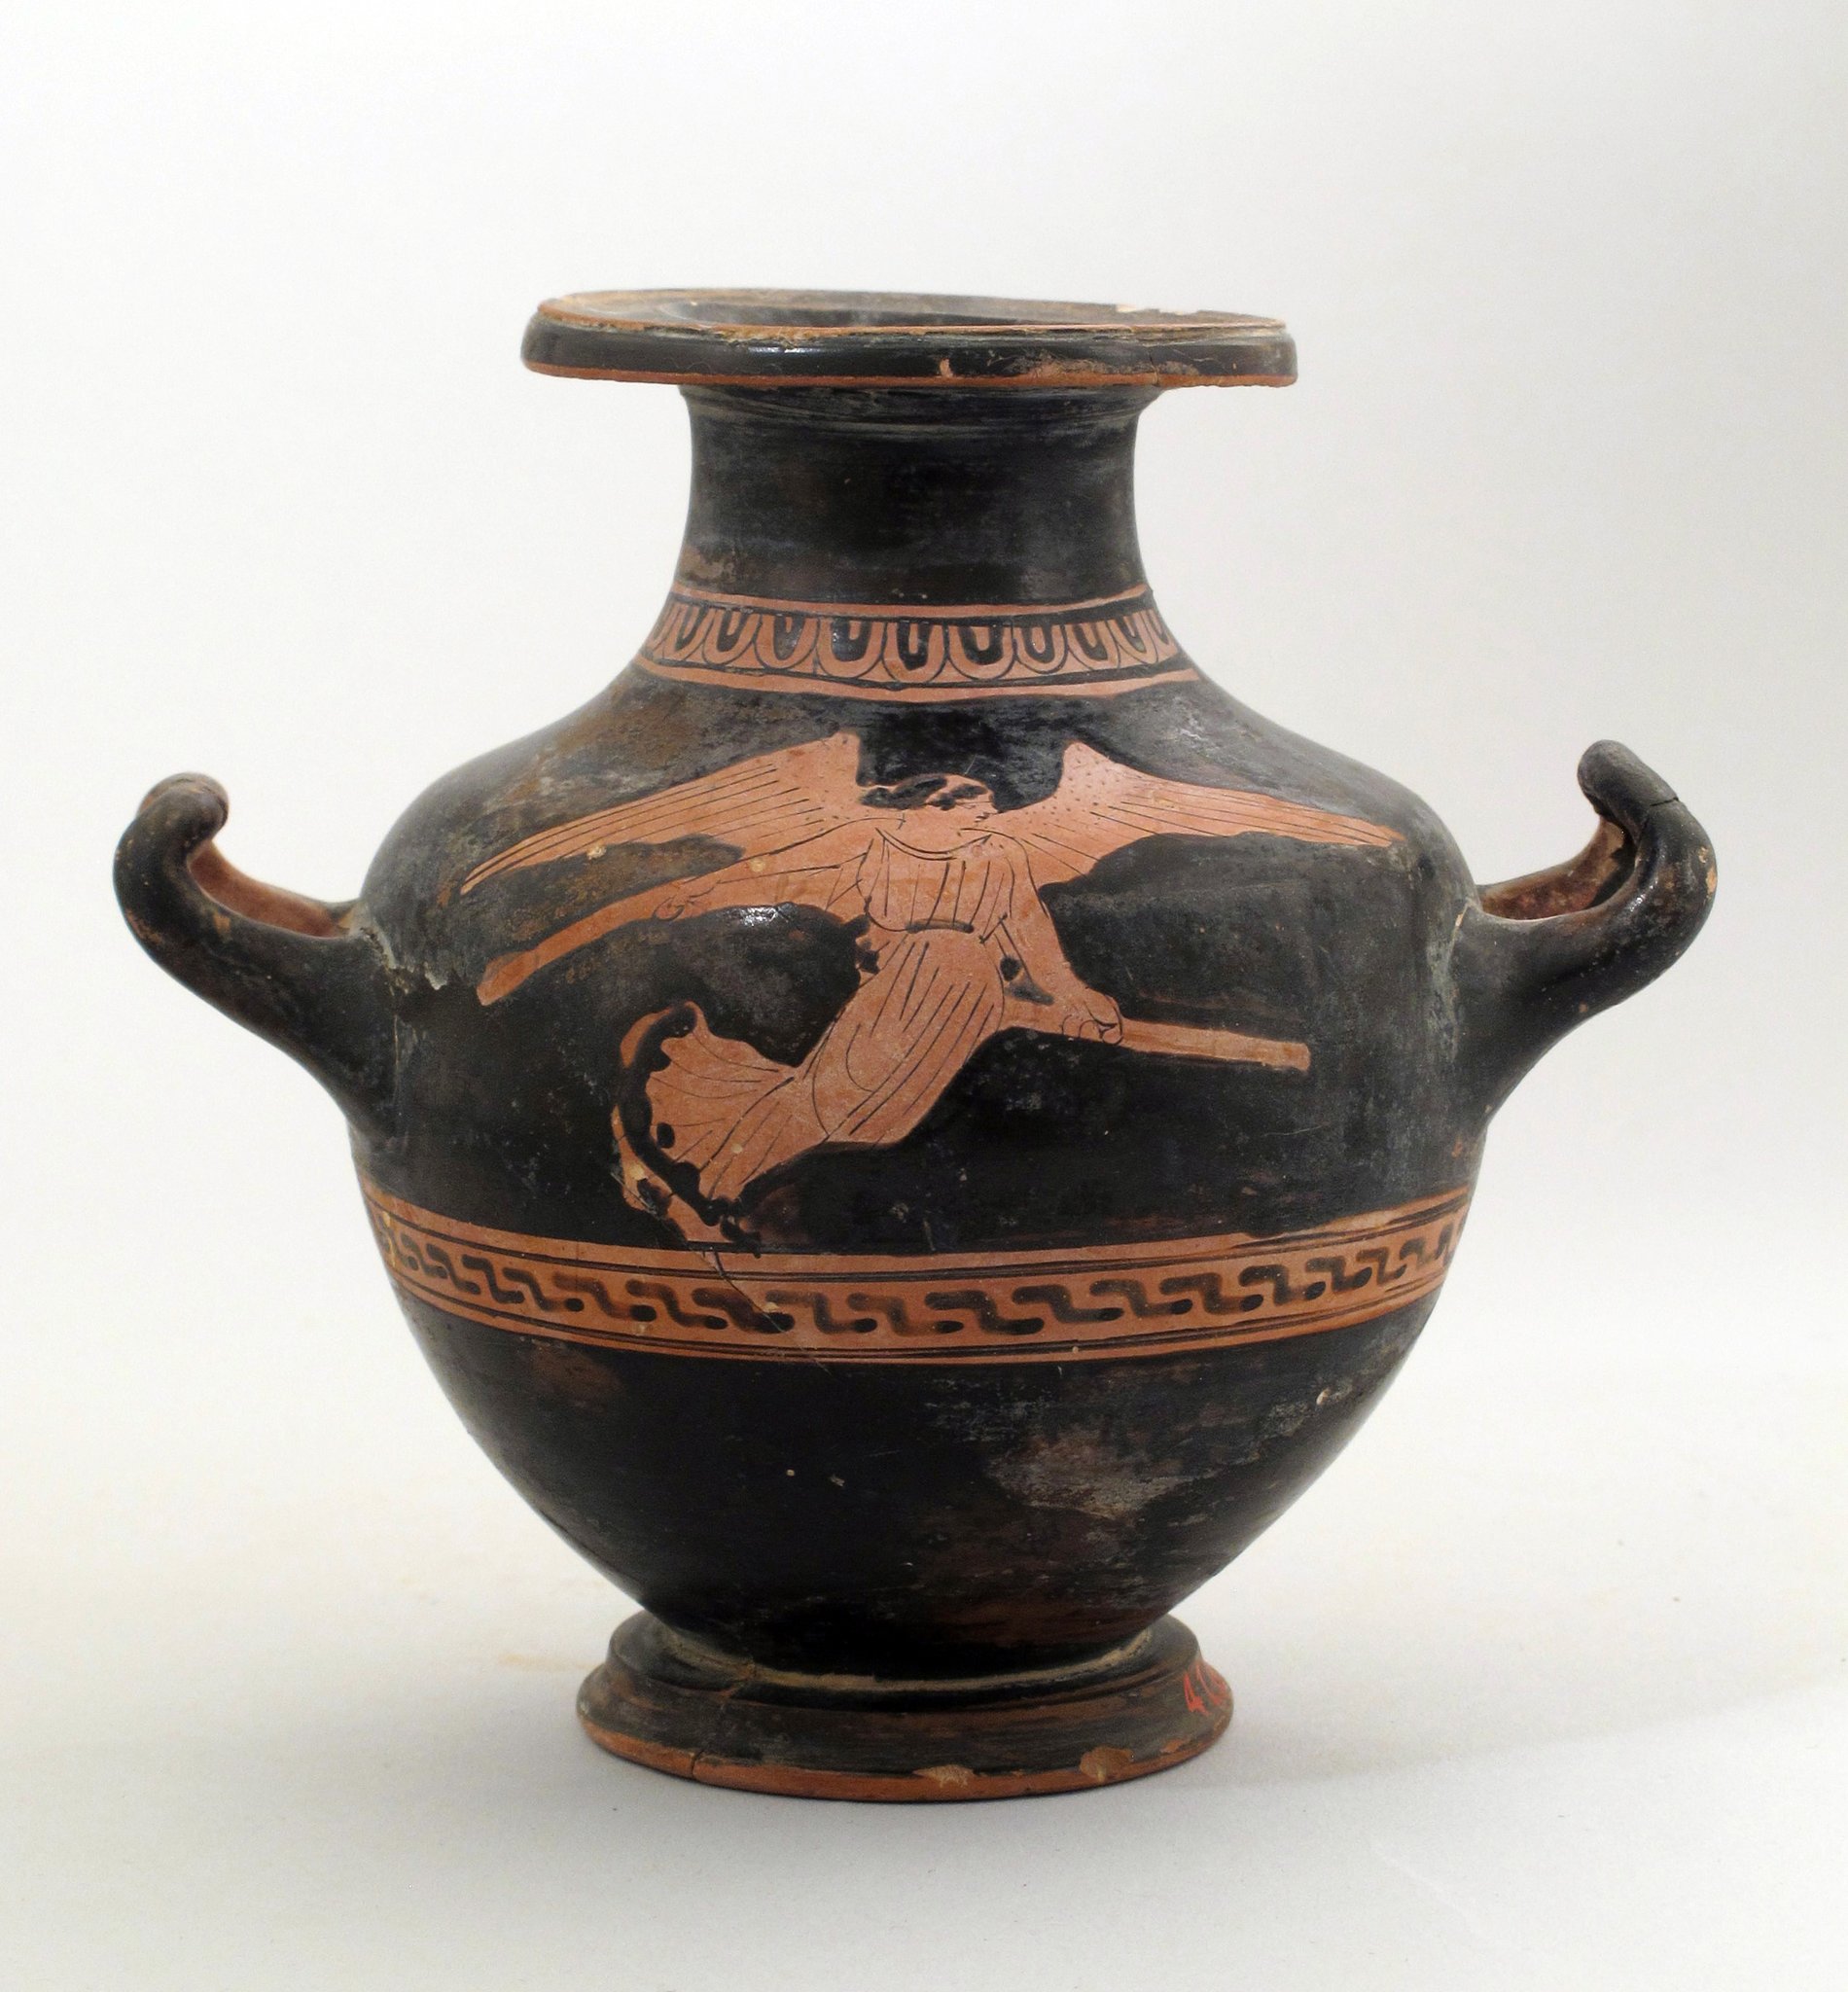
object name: hydria, miniature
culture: greek, attic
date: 434-401 BCE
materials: terracotta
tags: nike